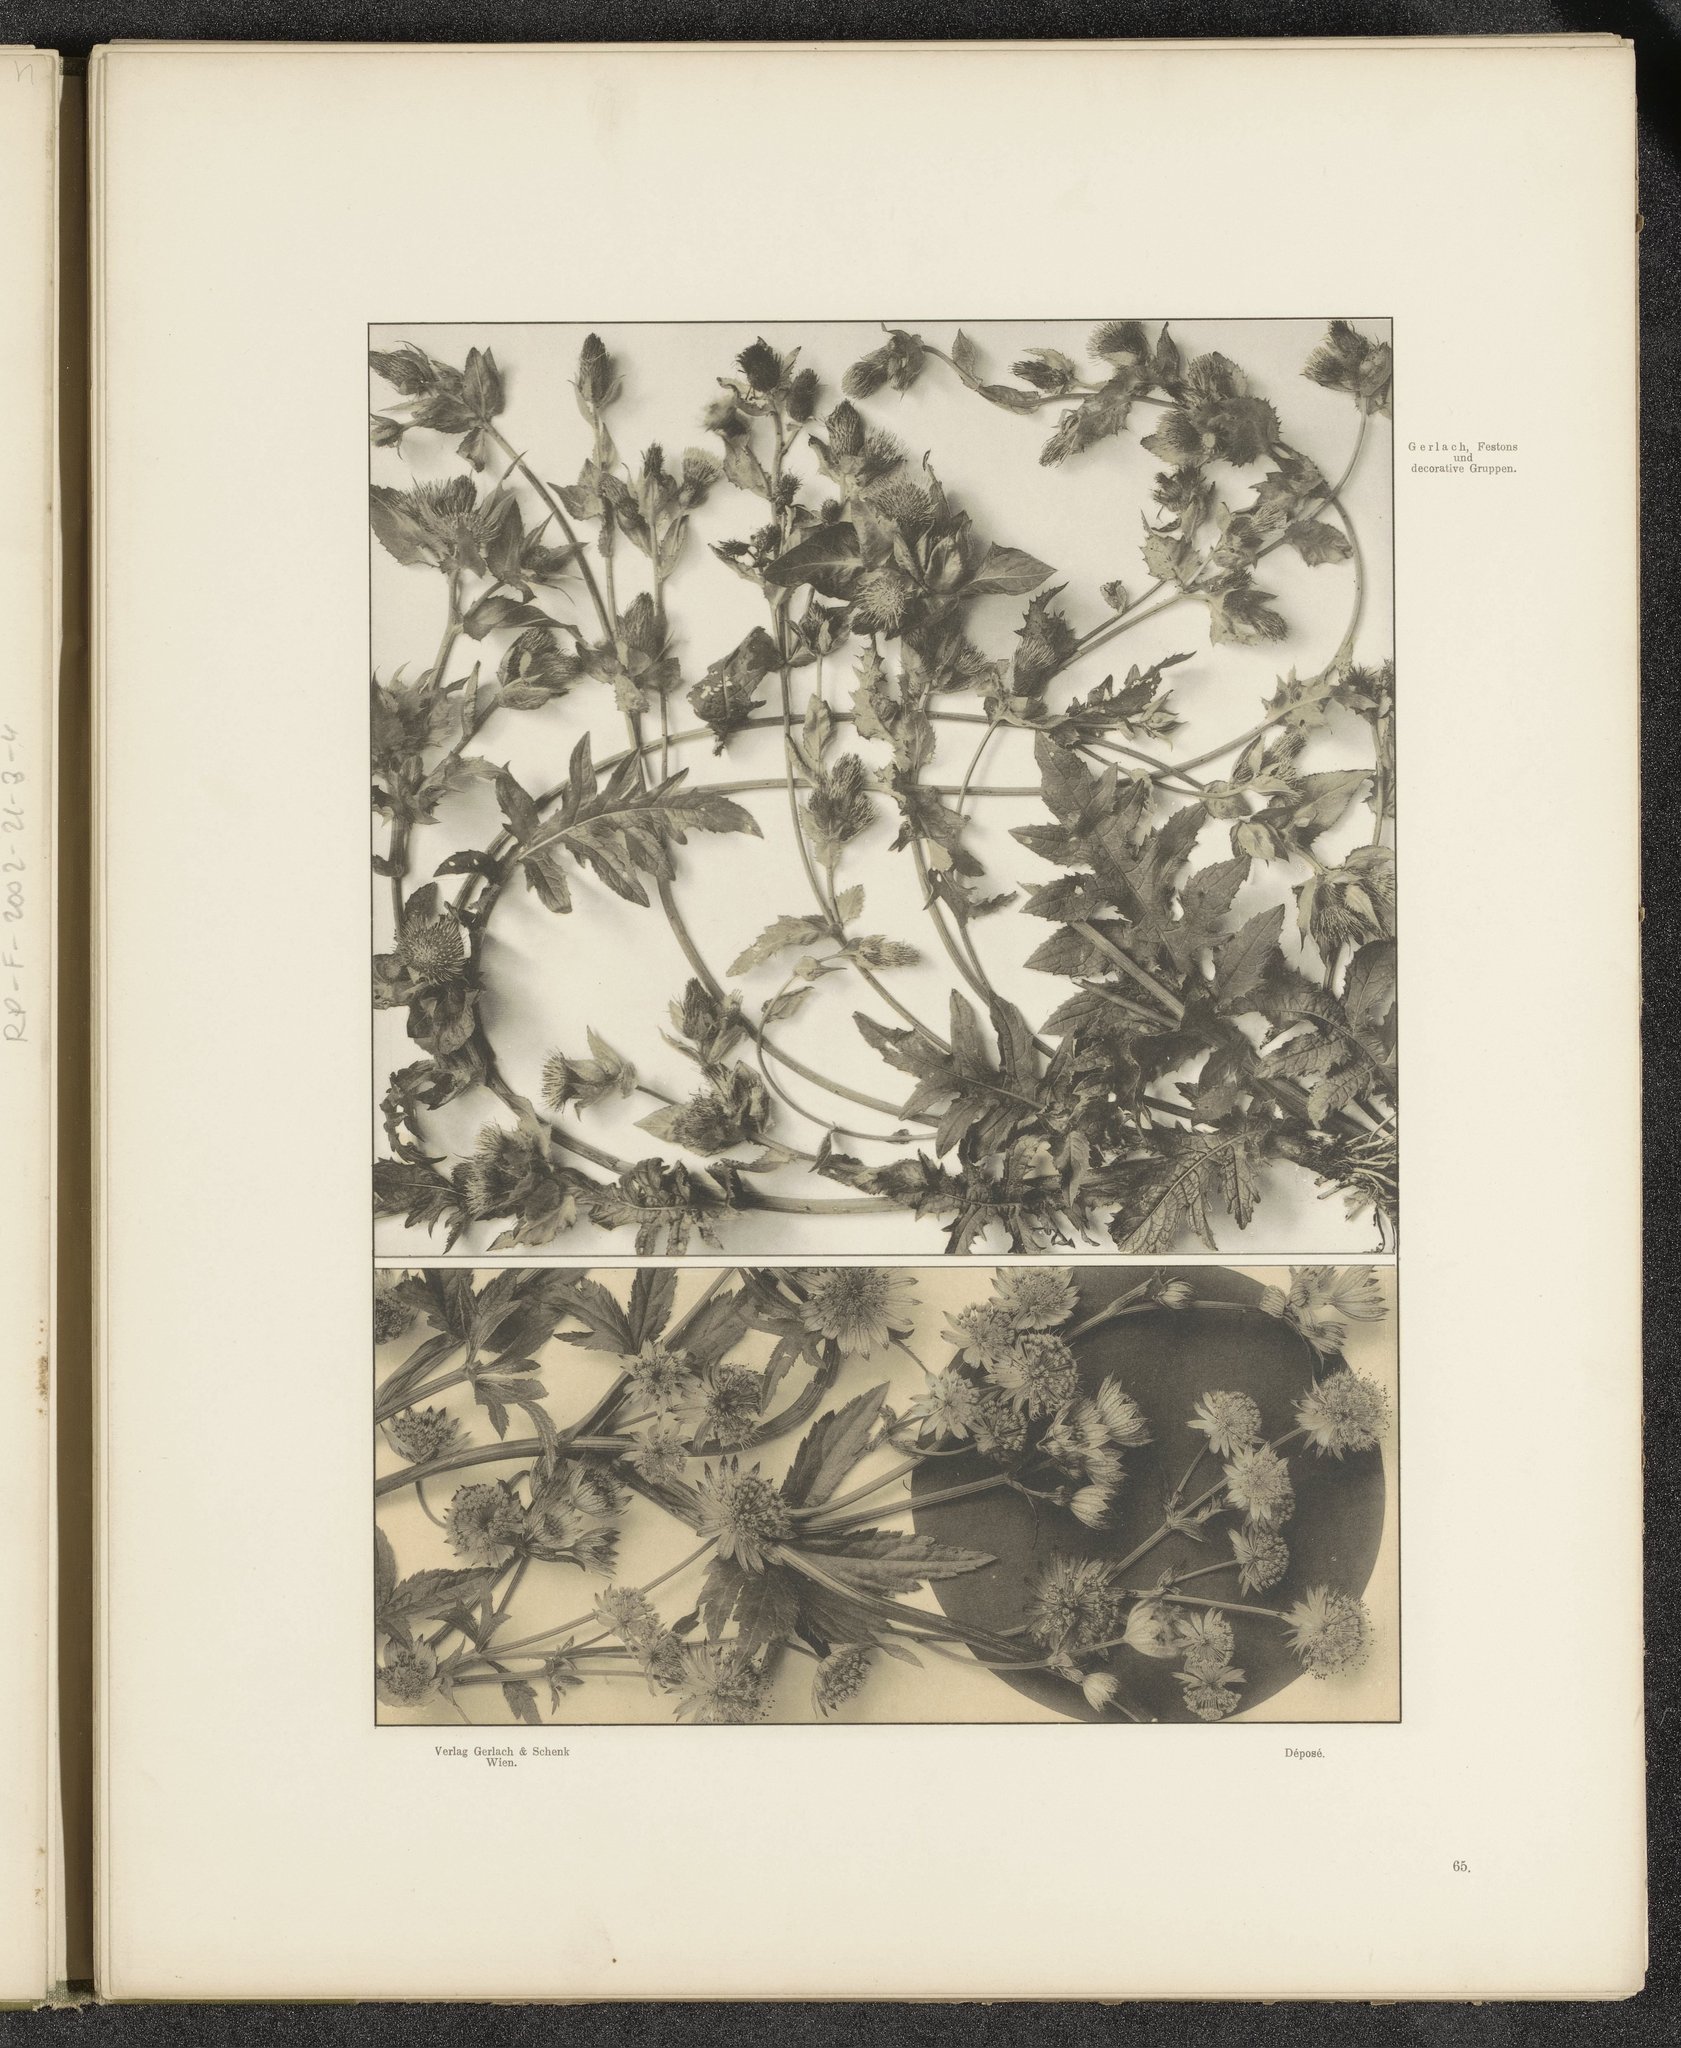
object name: photomechanical print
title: Twee vlakvullingen met distels en astrantia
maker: Anonymous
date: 1887-1897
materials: paper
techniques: photograph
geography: vienna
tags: foliage, tendrils, branches ~ ornament, plants and herbs: thistle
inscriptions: number: ‘65.’